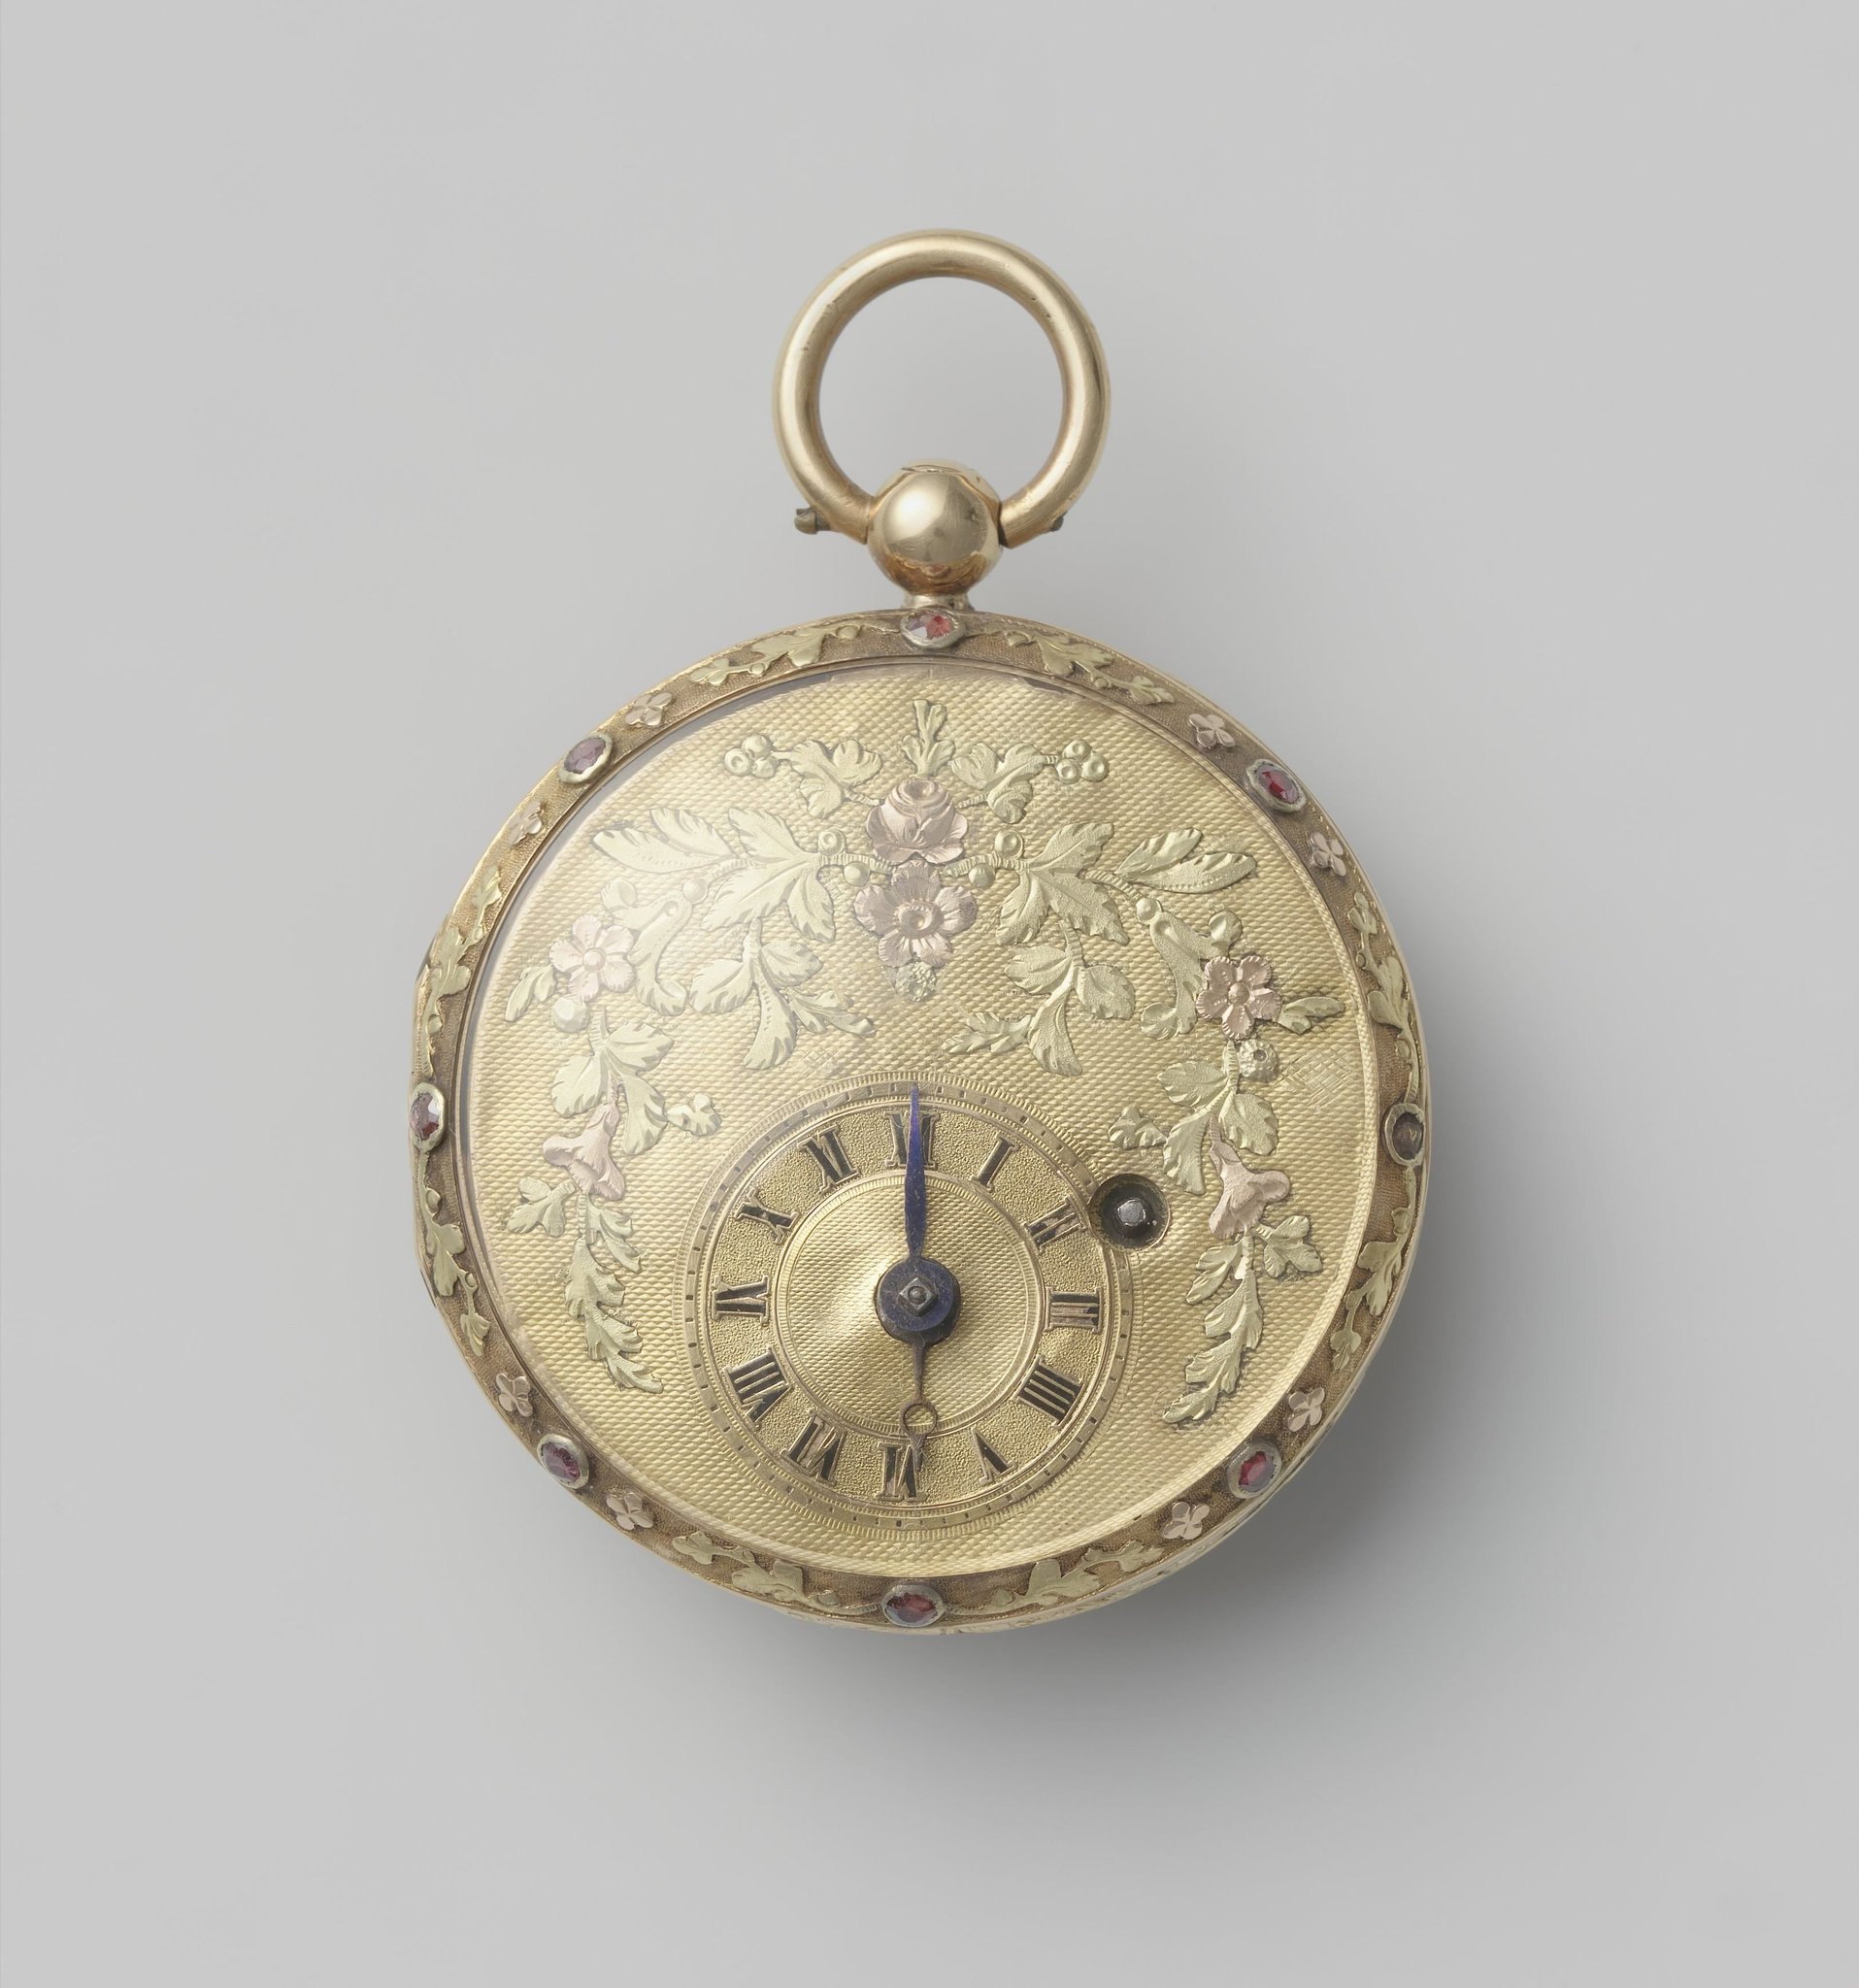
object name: jewellery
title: Watch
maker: Anonymous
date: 1825-1875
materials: coral, gold, gemstone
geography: switzerland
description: Gouden horloge met een gegraveerde en geciseleerde wijzerplaat met kleine cijferring. De achterbodem is geciseleerd en met blauwe en rode steentjes versierd.